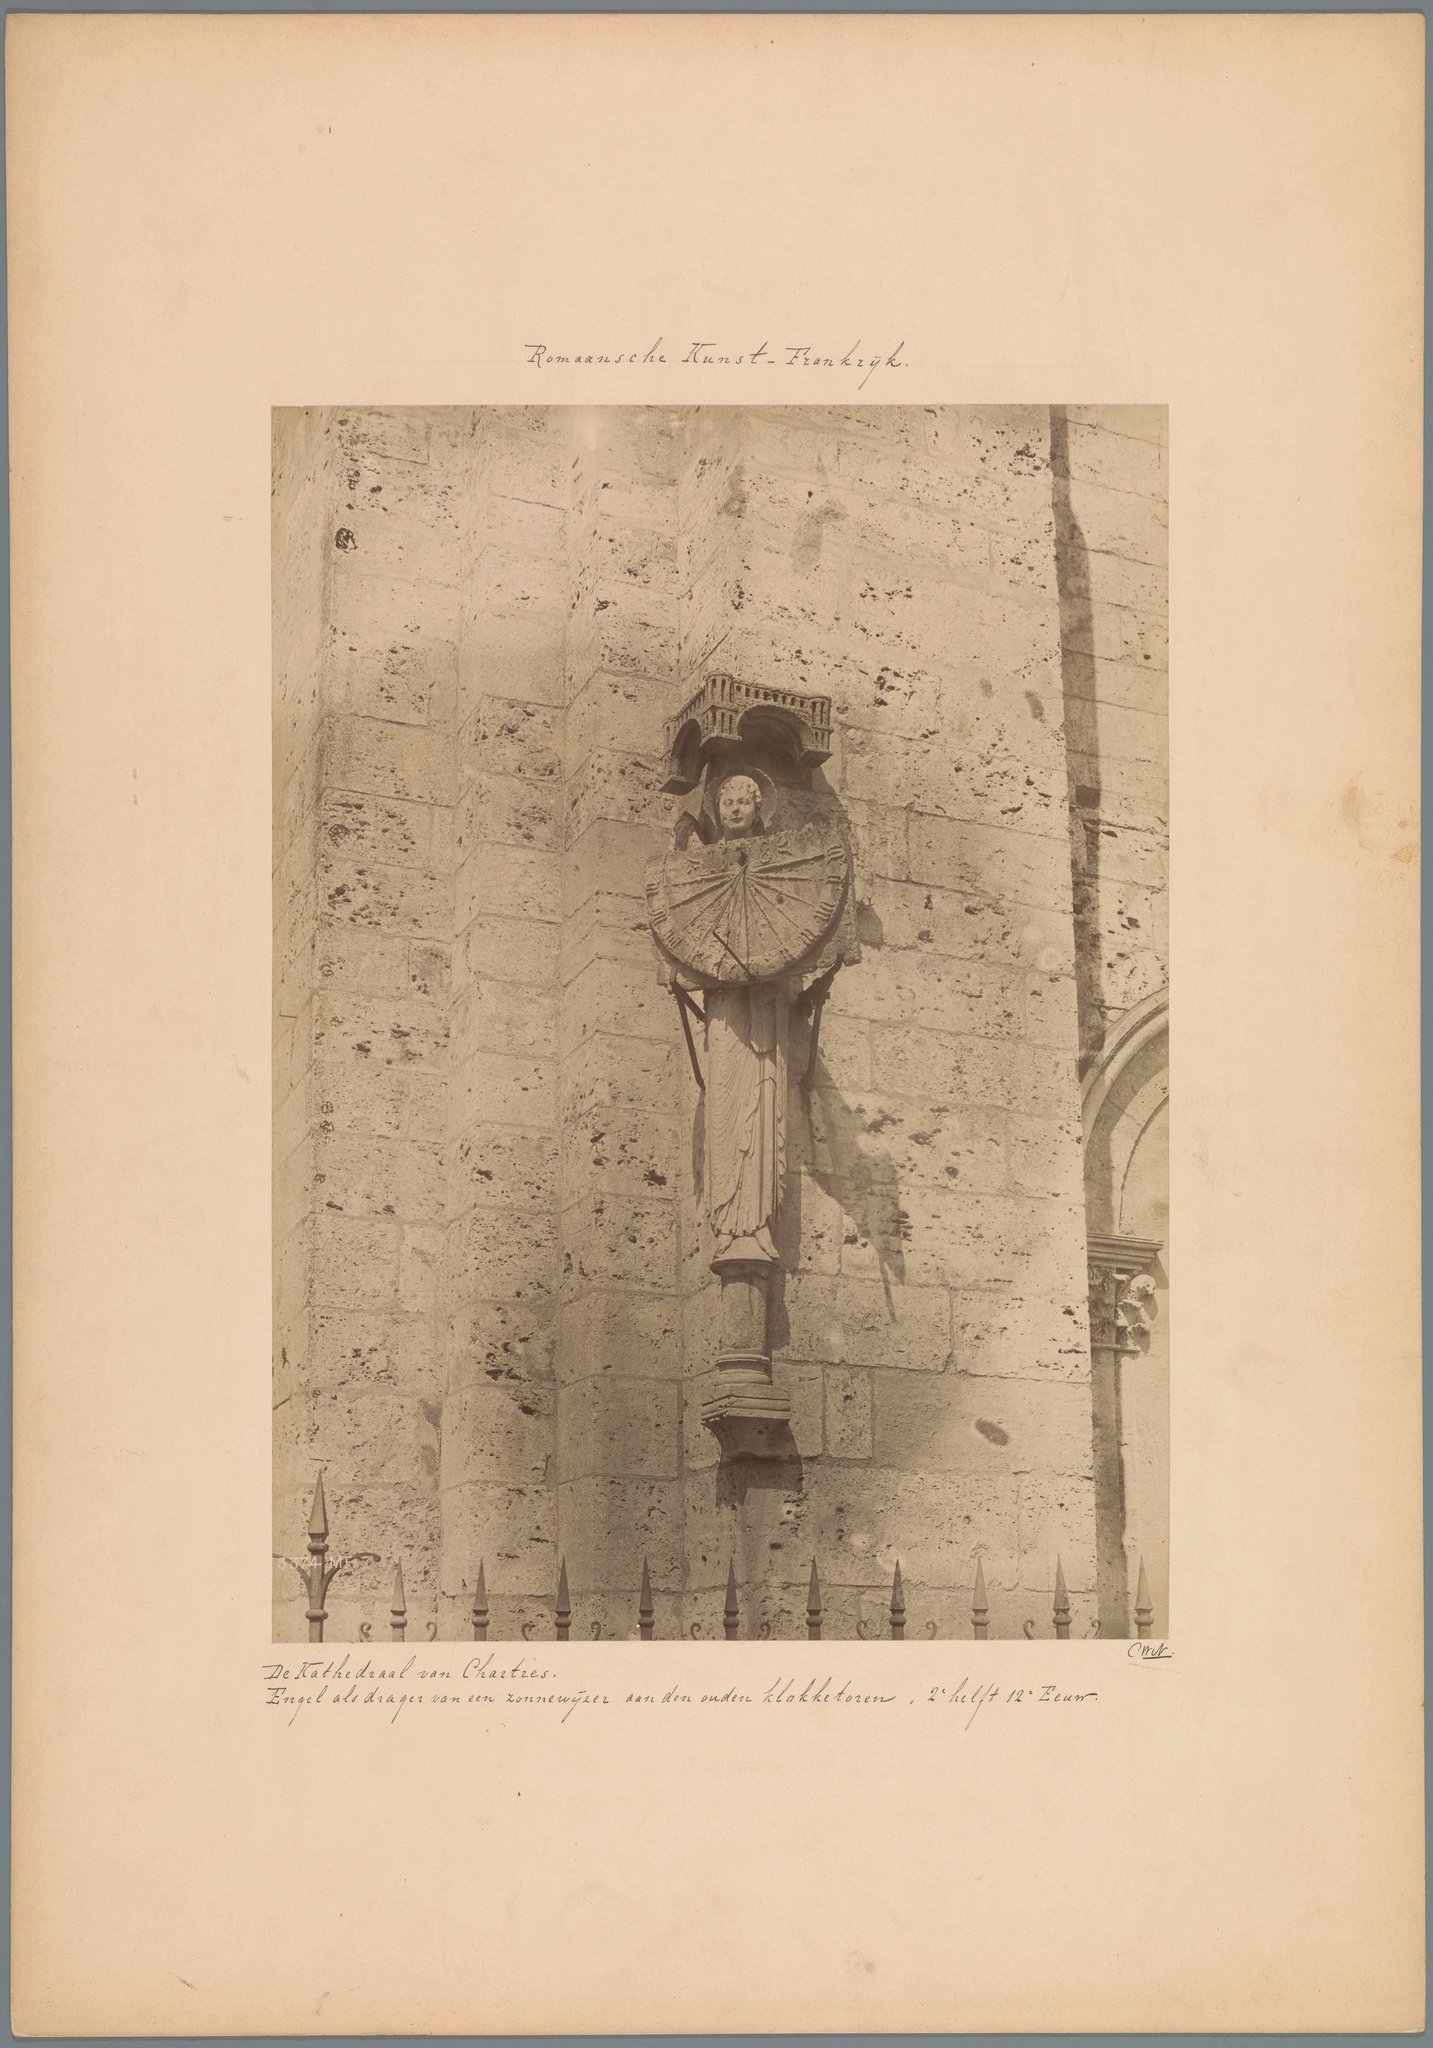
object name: photograph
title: Sculptuur van een engel met een zonnewijzer aan de gevel van de Kathedraal van Chartres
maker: j. kuhn (fotograaf)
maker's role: fotograaf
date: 1875-1900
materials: cardboard, photographic support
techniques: albumen print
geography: chartres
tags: church (exterior), sculpture, sundial, angels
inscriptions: collector's mark: ‘INSTITUUT VOOR KUNST- NIJVERHEIDSONDERWIJS GABRIËL METSUSTRAAT No. 16. AMSTERDAM’, collector's mark: ‘KUNSTNIJVERHEIDSCHOOL QUELLINUS AMSTERDAM FRANS HALSSTRAAT 14.’, inscription: ‘Romaansche Kunst - Frankrijk. De Kathedraal van Chartres. Engel als drager van een zonnewijzer aan den ouden klokketoren , 2e helft 12e Eeuw.’, inscription: ‘CWN.’, number: ‘3374’, inscription: ‘MF’, name: ‘J. KUHN 220 Rue de Rivoli PARIS’